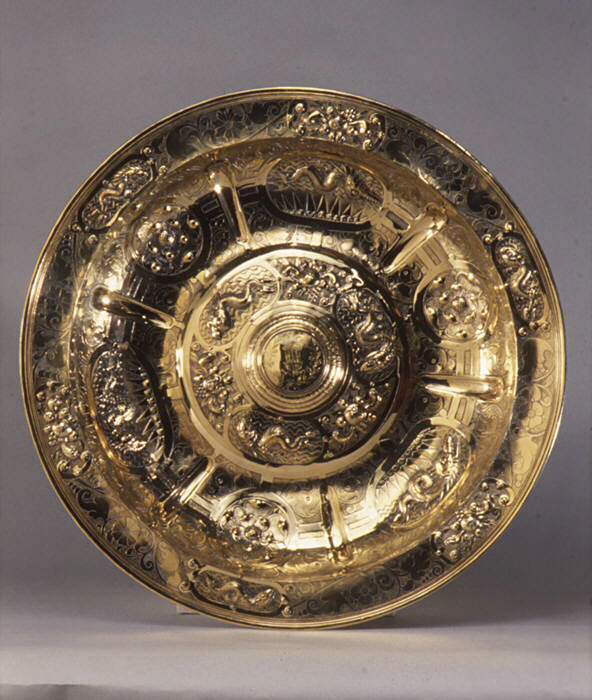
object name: basin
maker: symon owen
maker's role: maker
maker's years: 1595-1624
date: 1610-1611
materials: silver gilt